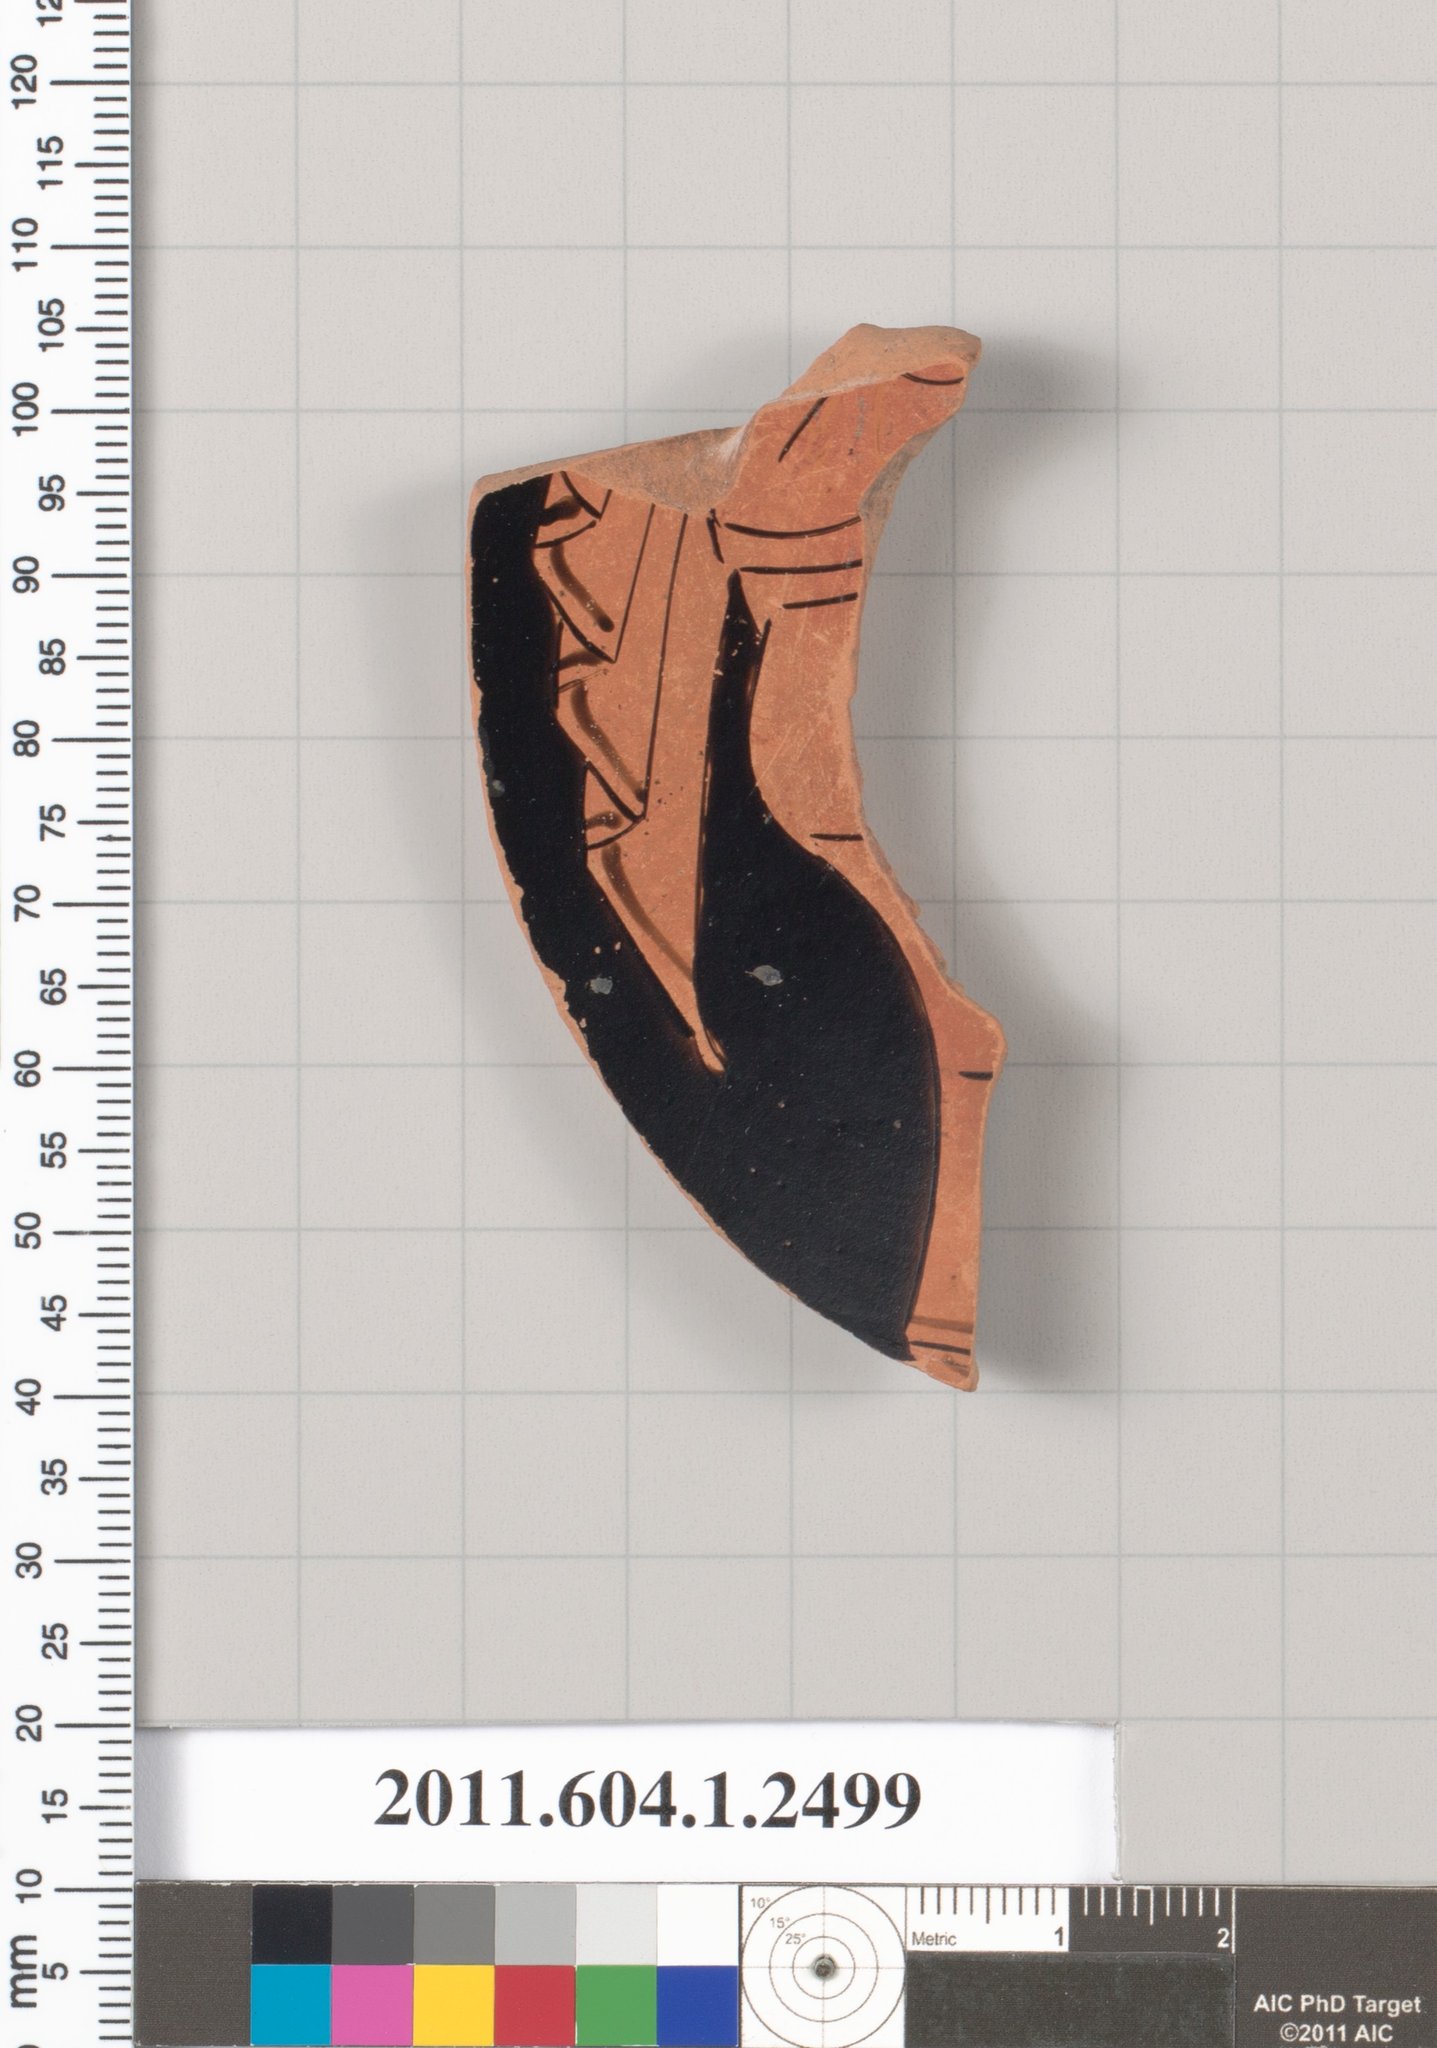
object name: kylix fragment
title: Terracotta fragment of a kylix (drinking cup)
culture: greek, attic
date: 500-476 BCE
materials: terracotta